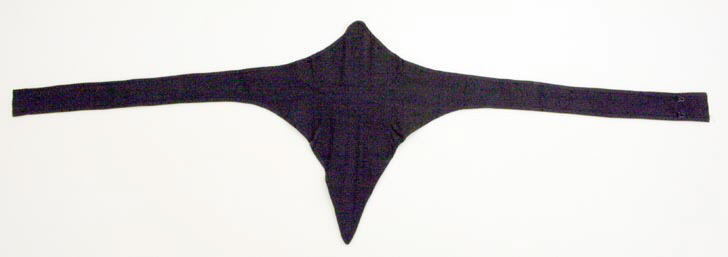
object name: belt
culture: american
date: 1860-1869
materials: silk